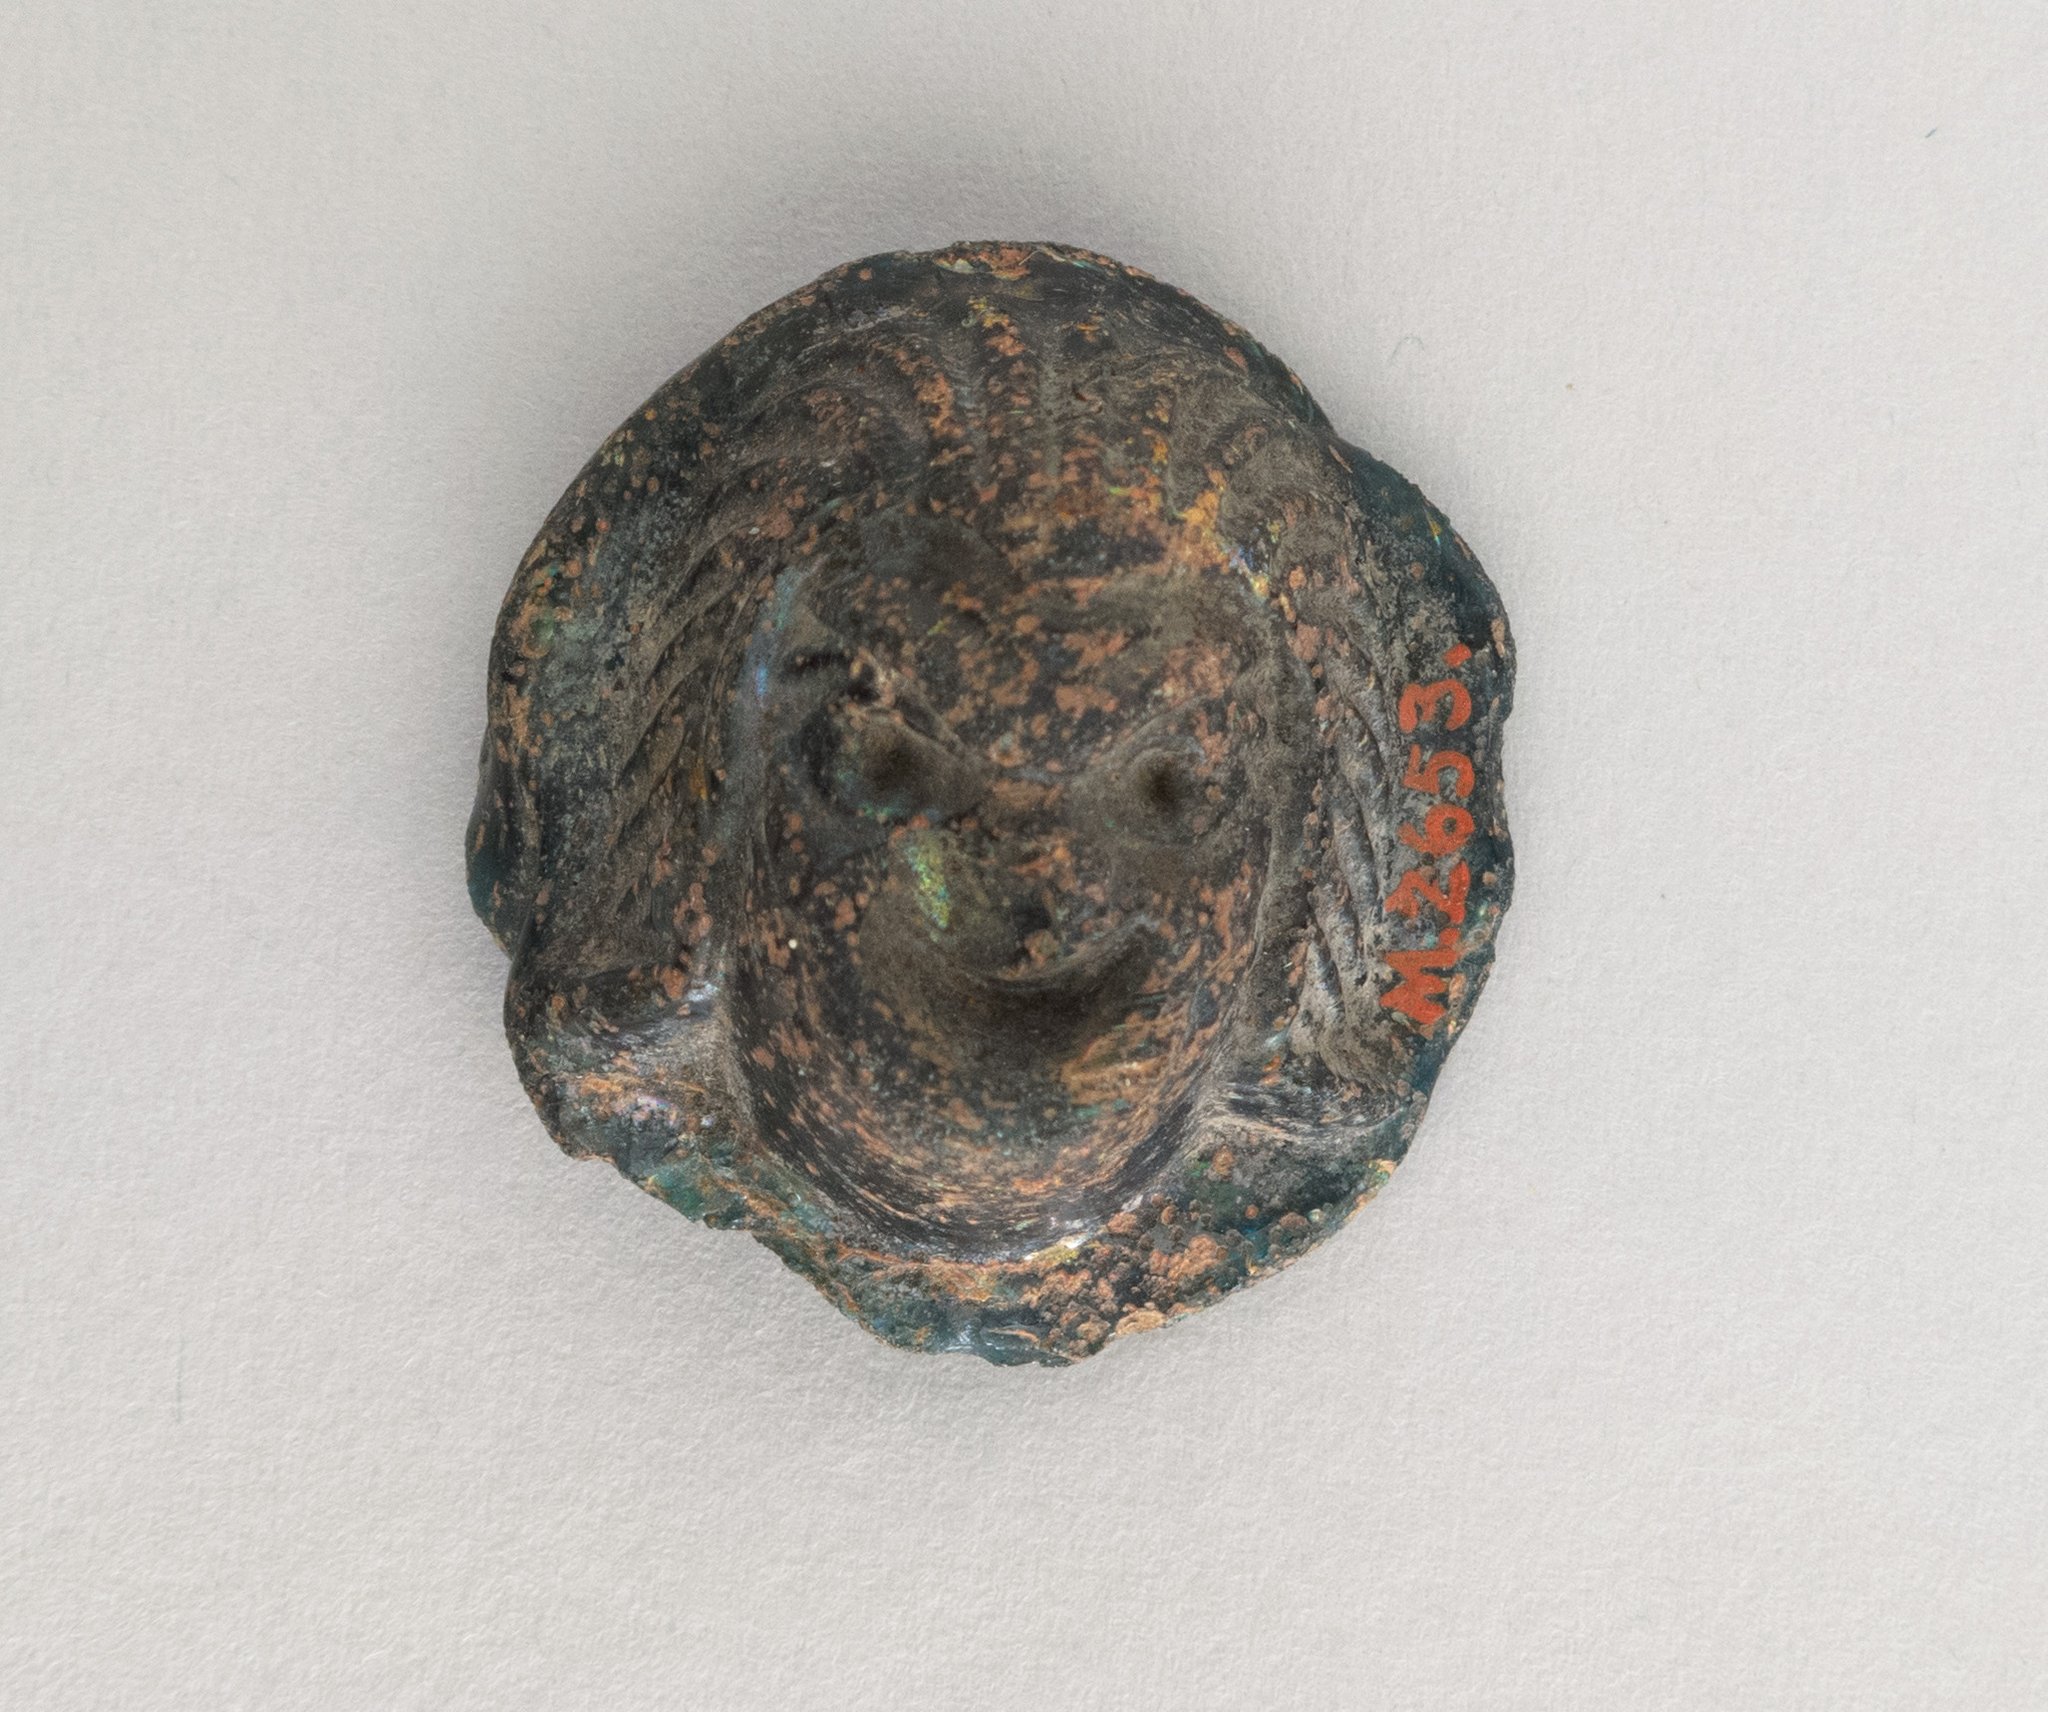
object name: appliqué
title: Glass appliqué with theatrical mask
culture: roman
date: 101-400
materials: glass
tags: masks